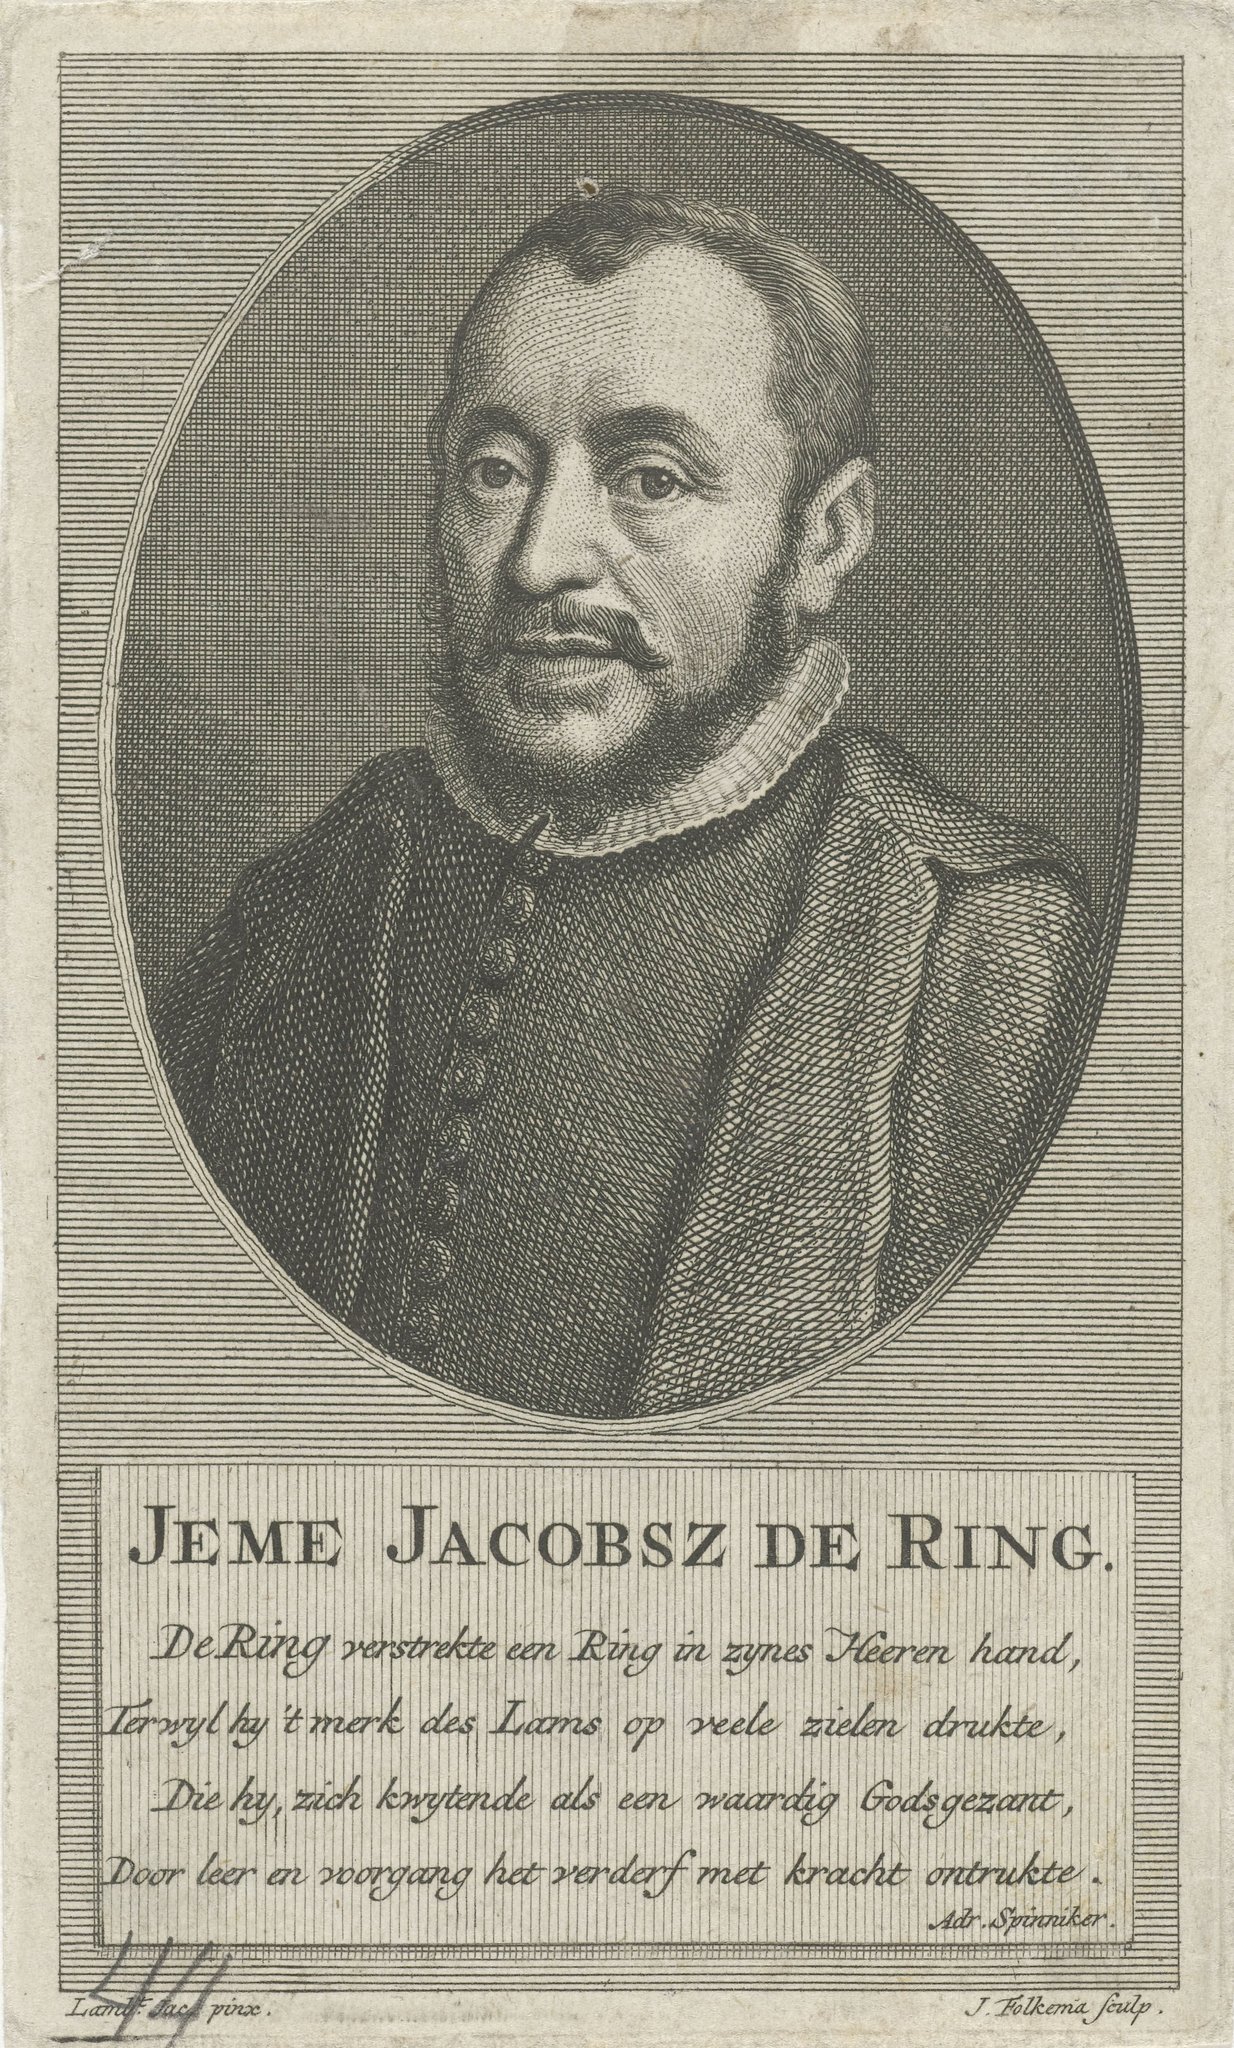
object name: print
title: Portret van Yeme de Ringh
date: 1702-1767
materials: paper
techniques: engraving, etching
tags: harlingen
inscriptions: collector's mark: Lugt 2228, inscription: ‘44’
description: Portretbuste in ovaal naar links van predikant Yeme de Ringh, blootshoofds. Onder het portret staan de naam van de geportretteerde en een vierregelig vers in het Nederlands.